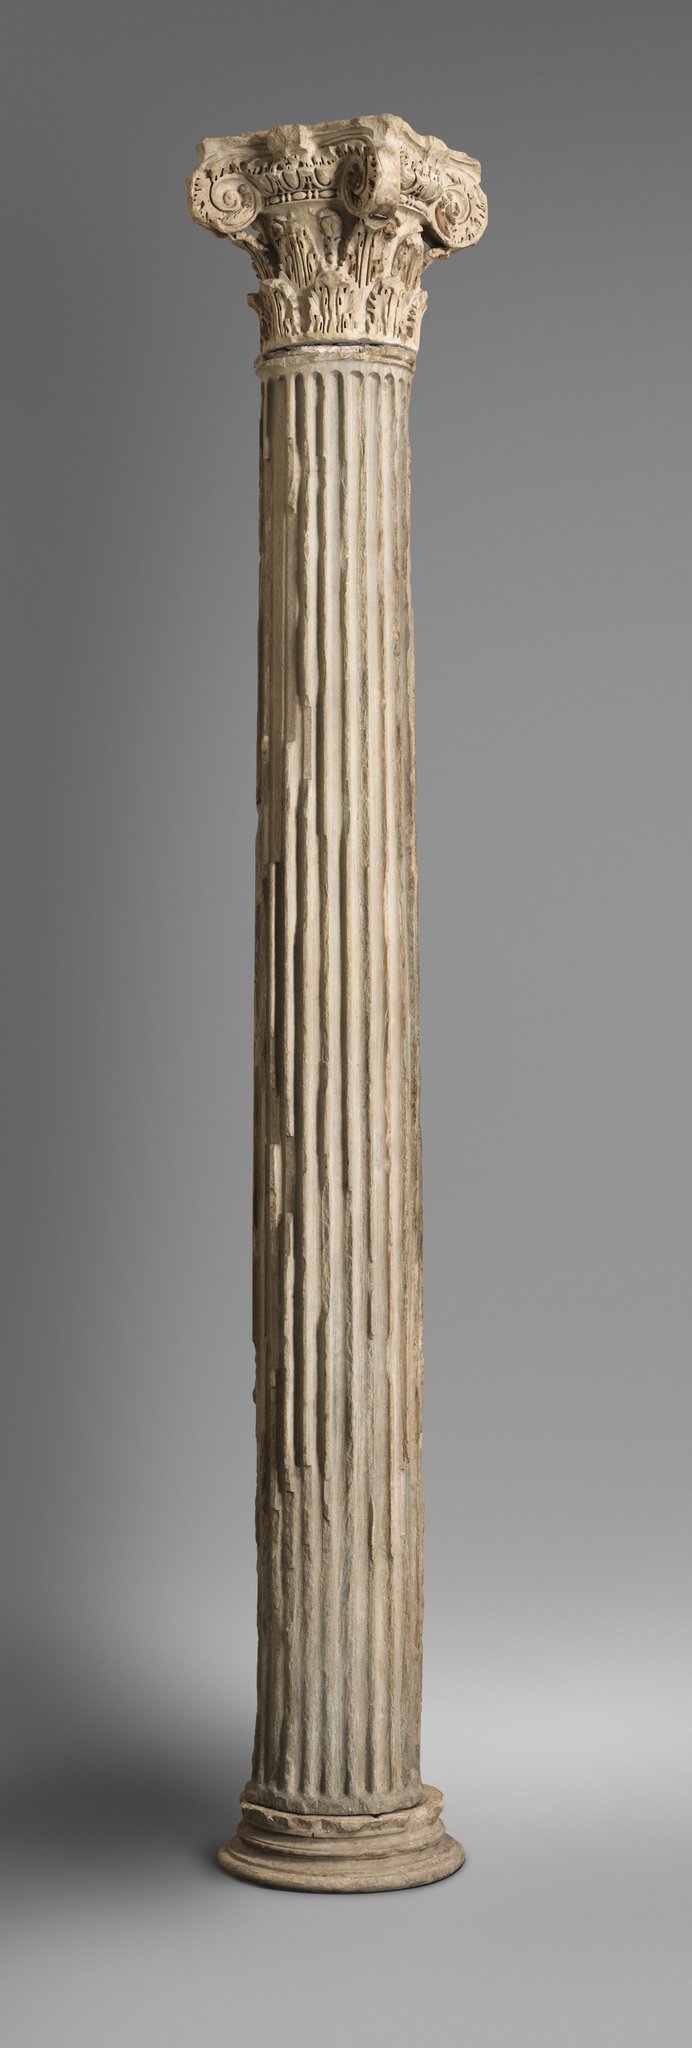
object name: column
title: Marble column with base and capital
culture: roman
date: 117-138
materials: marble